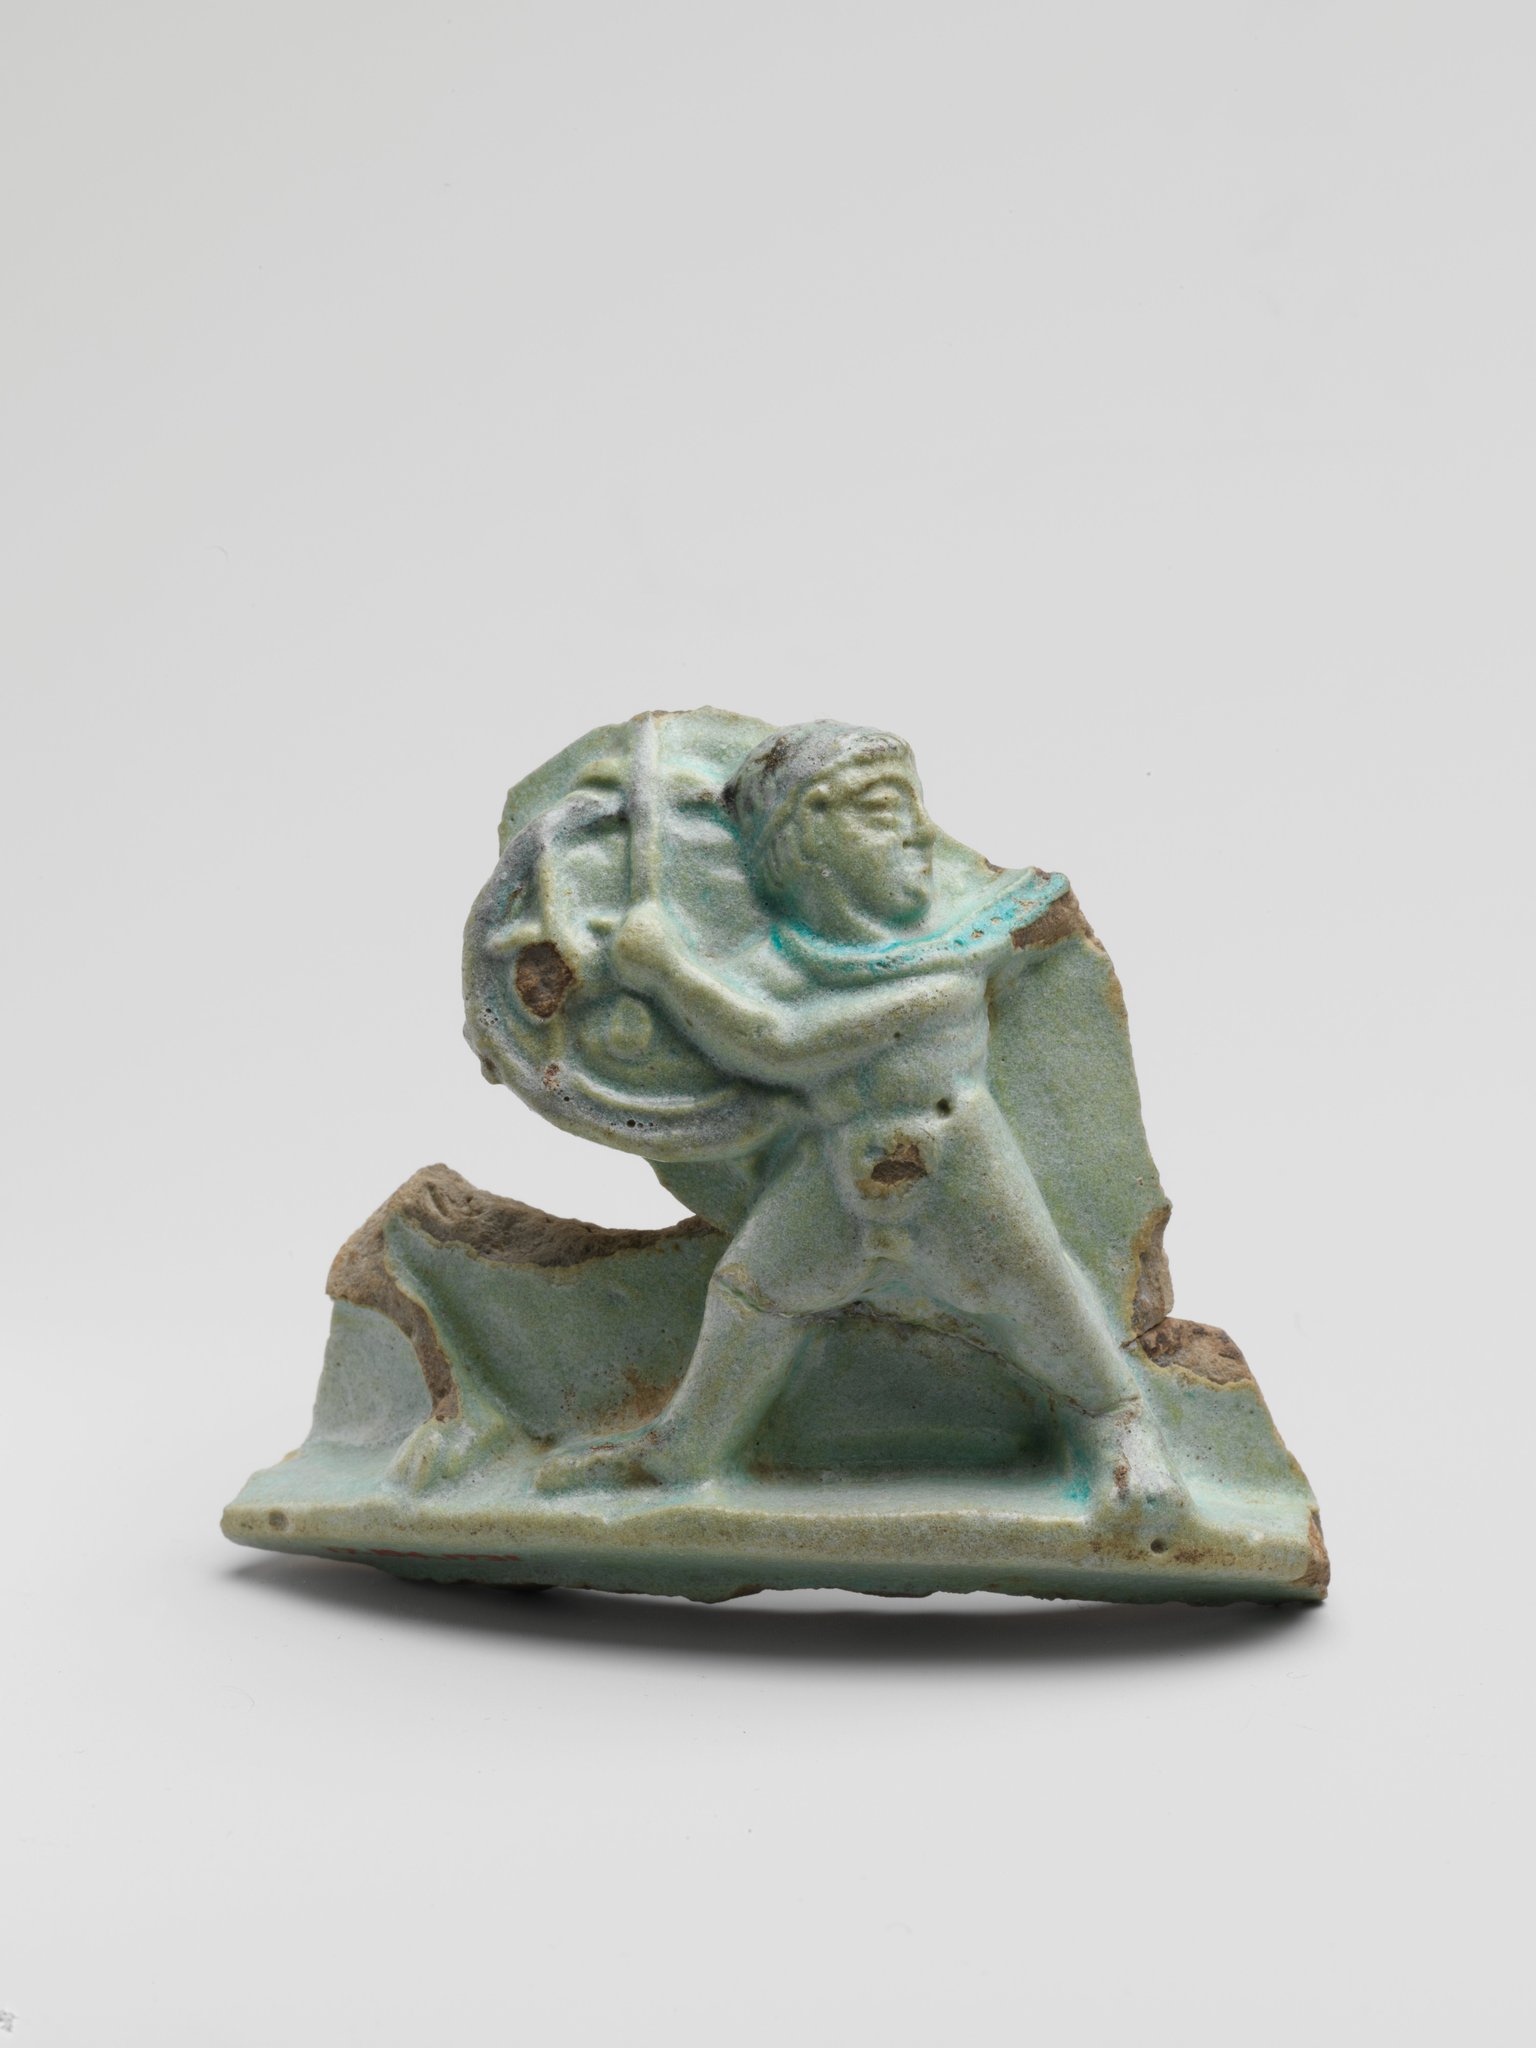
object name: vase fragment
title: Faience vase fragment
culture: egyptian or roman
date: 34 BCE-100 CE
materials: terracotta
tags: shields,swords,men,warriors